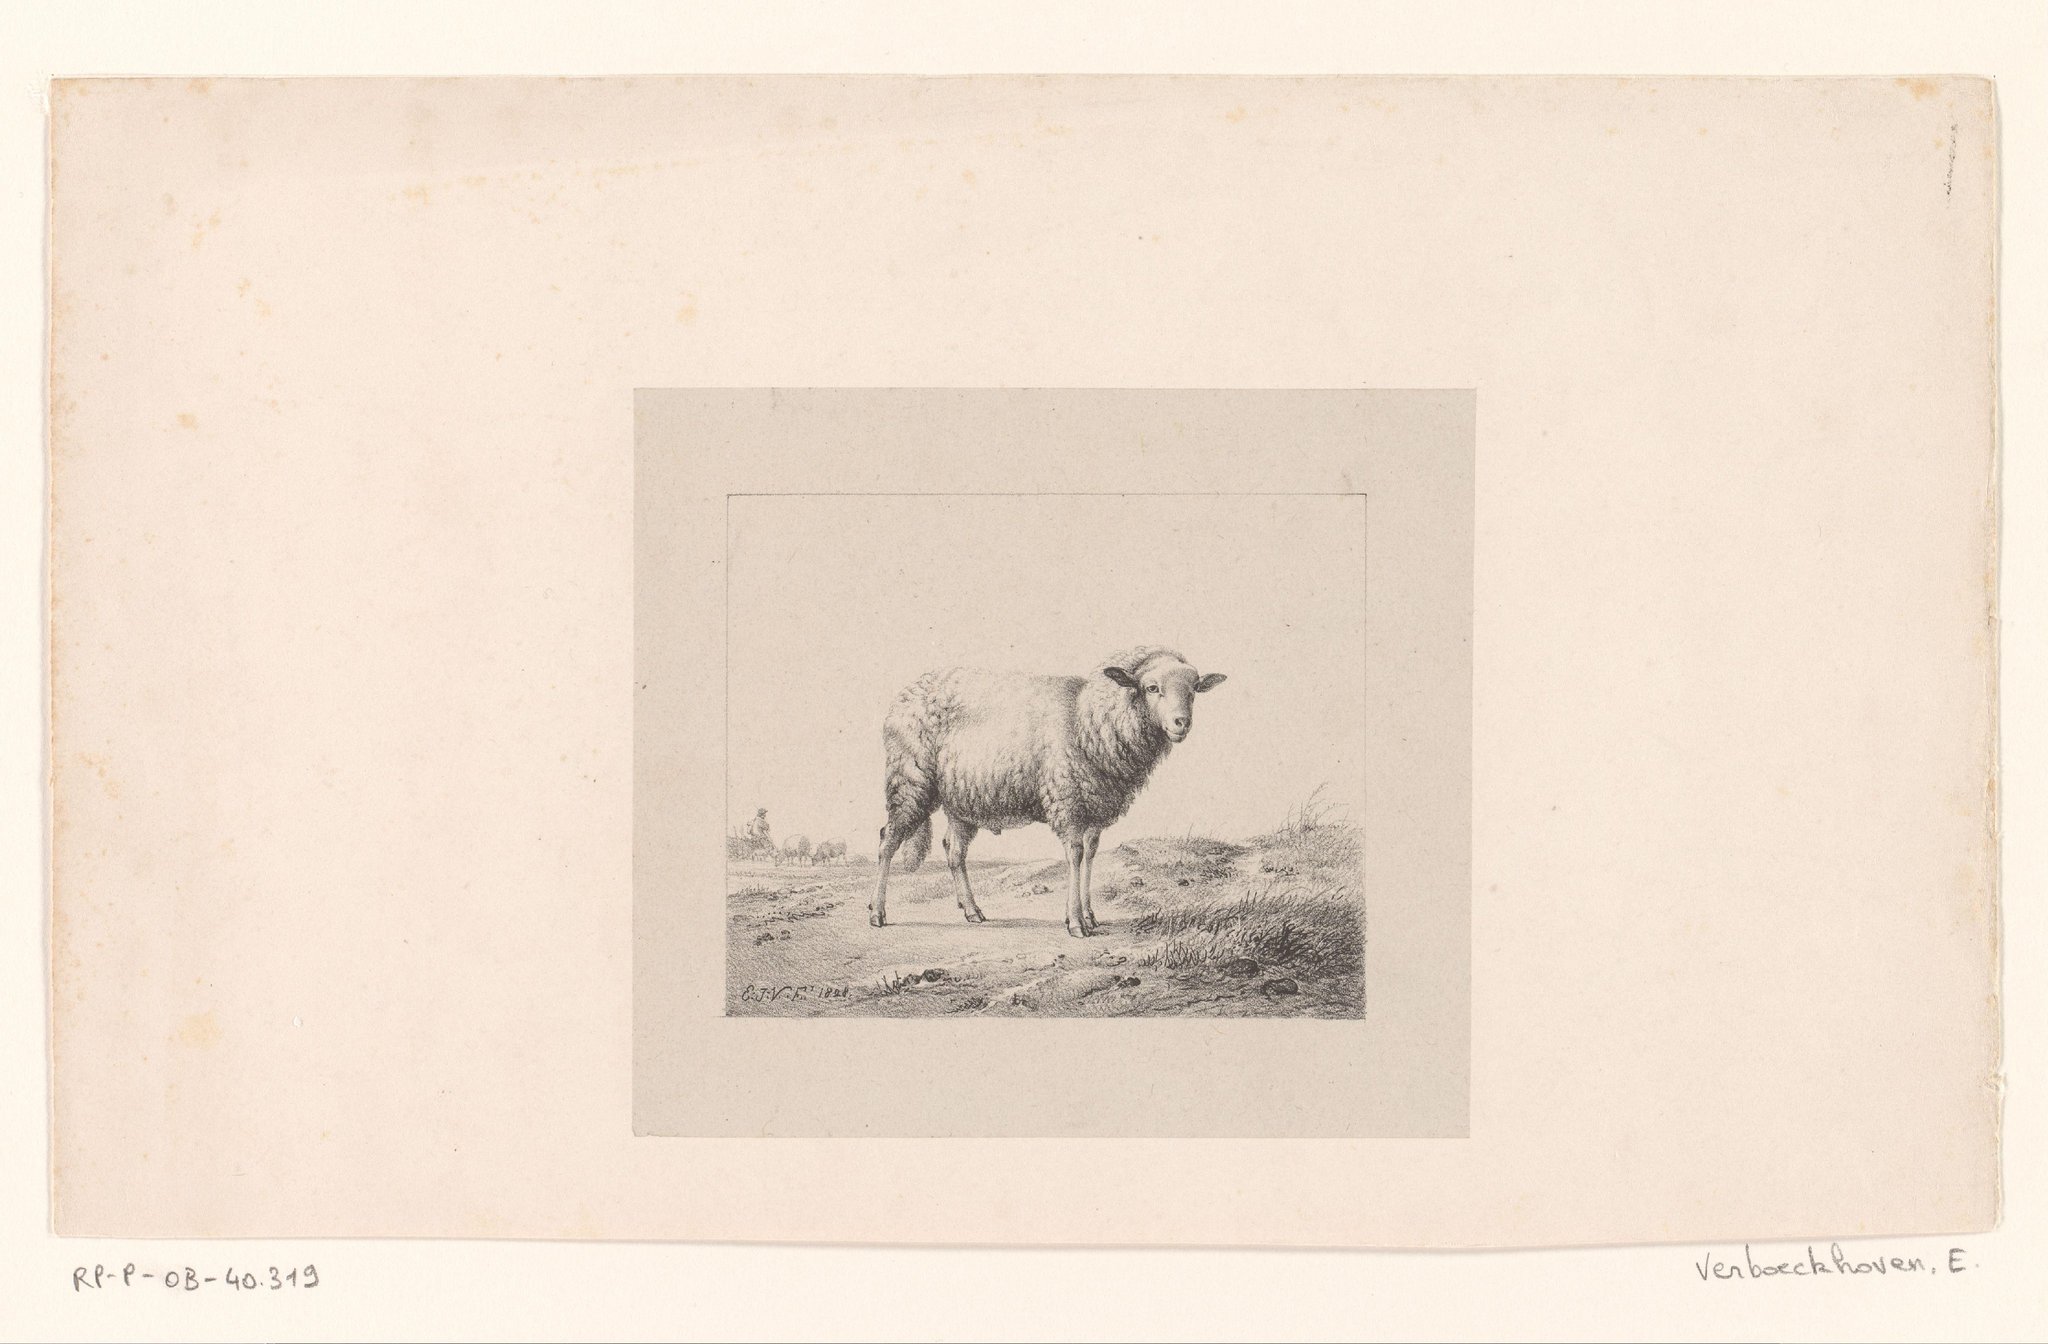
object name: print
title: Schaap in een weiland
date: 1828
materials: paper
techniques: lithograph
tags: herding, herdsman, herdswoman, shepherd, shepherdess, cowherd, etc., sheep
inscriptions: date